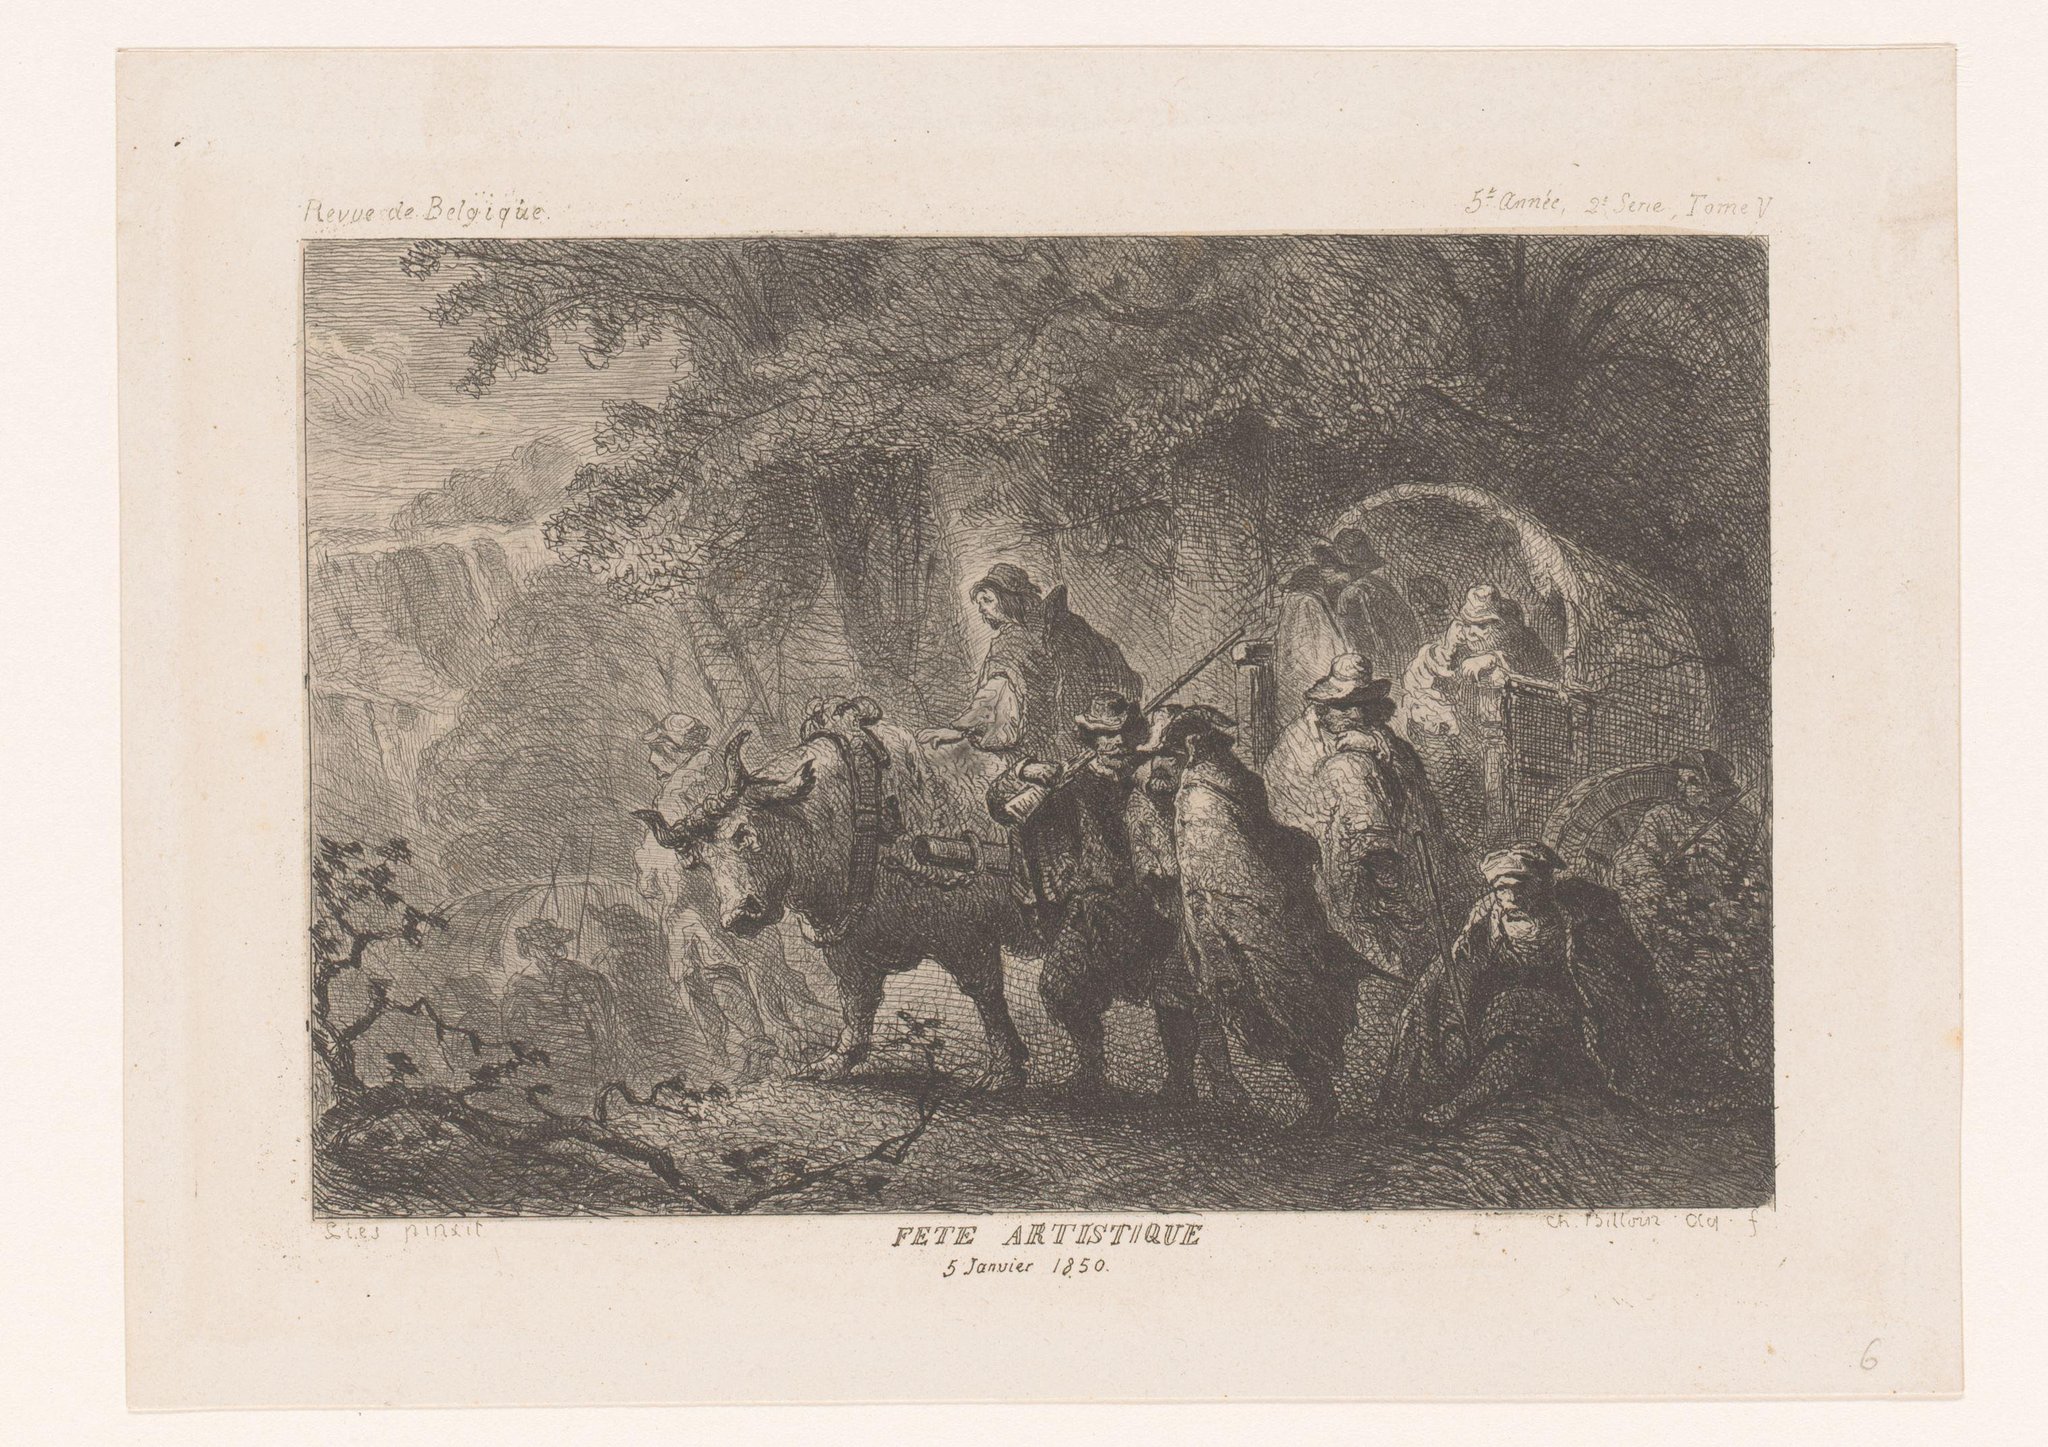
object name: print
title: Fete Artistique 5 janvier 1850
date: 1869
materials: paper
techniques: etching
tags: forest, wood, covered wagon, hooded wagon, 'en route', traveller under way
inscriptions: collector's mark: Lugt 1485, collector's mark, `: Lugt 2228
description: Prent uit: La Revue Belgique, jrg. 5, p. 175. In de literatuur wordt deze prent aangeduid als "Le convoi de bohémiens". Onduidelijk is of hier inwoners van Bohemen dan wel Roma worden bedoeld.